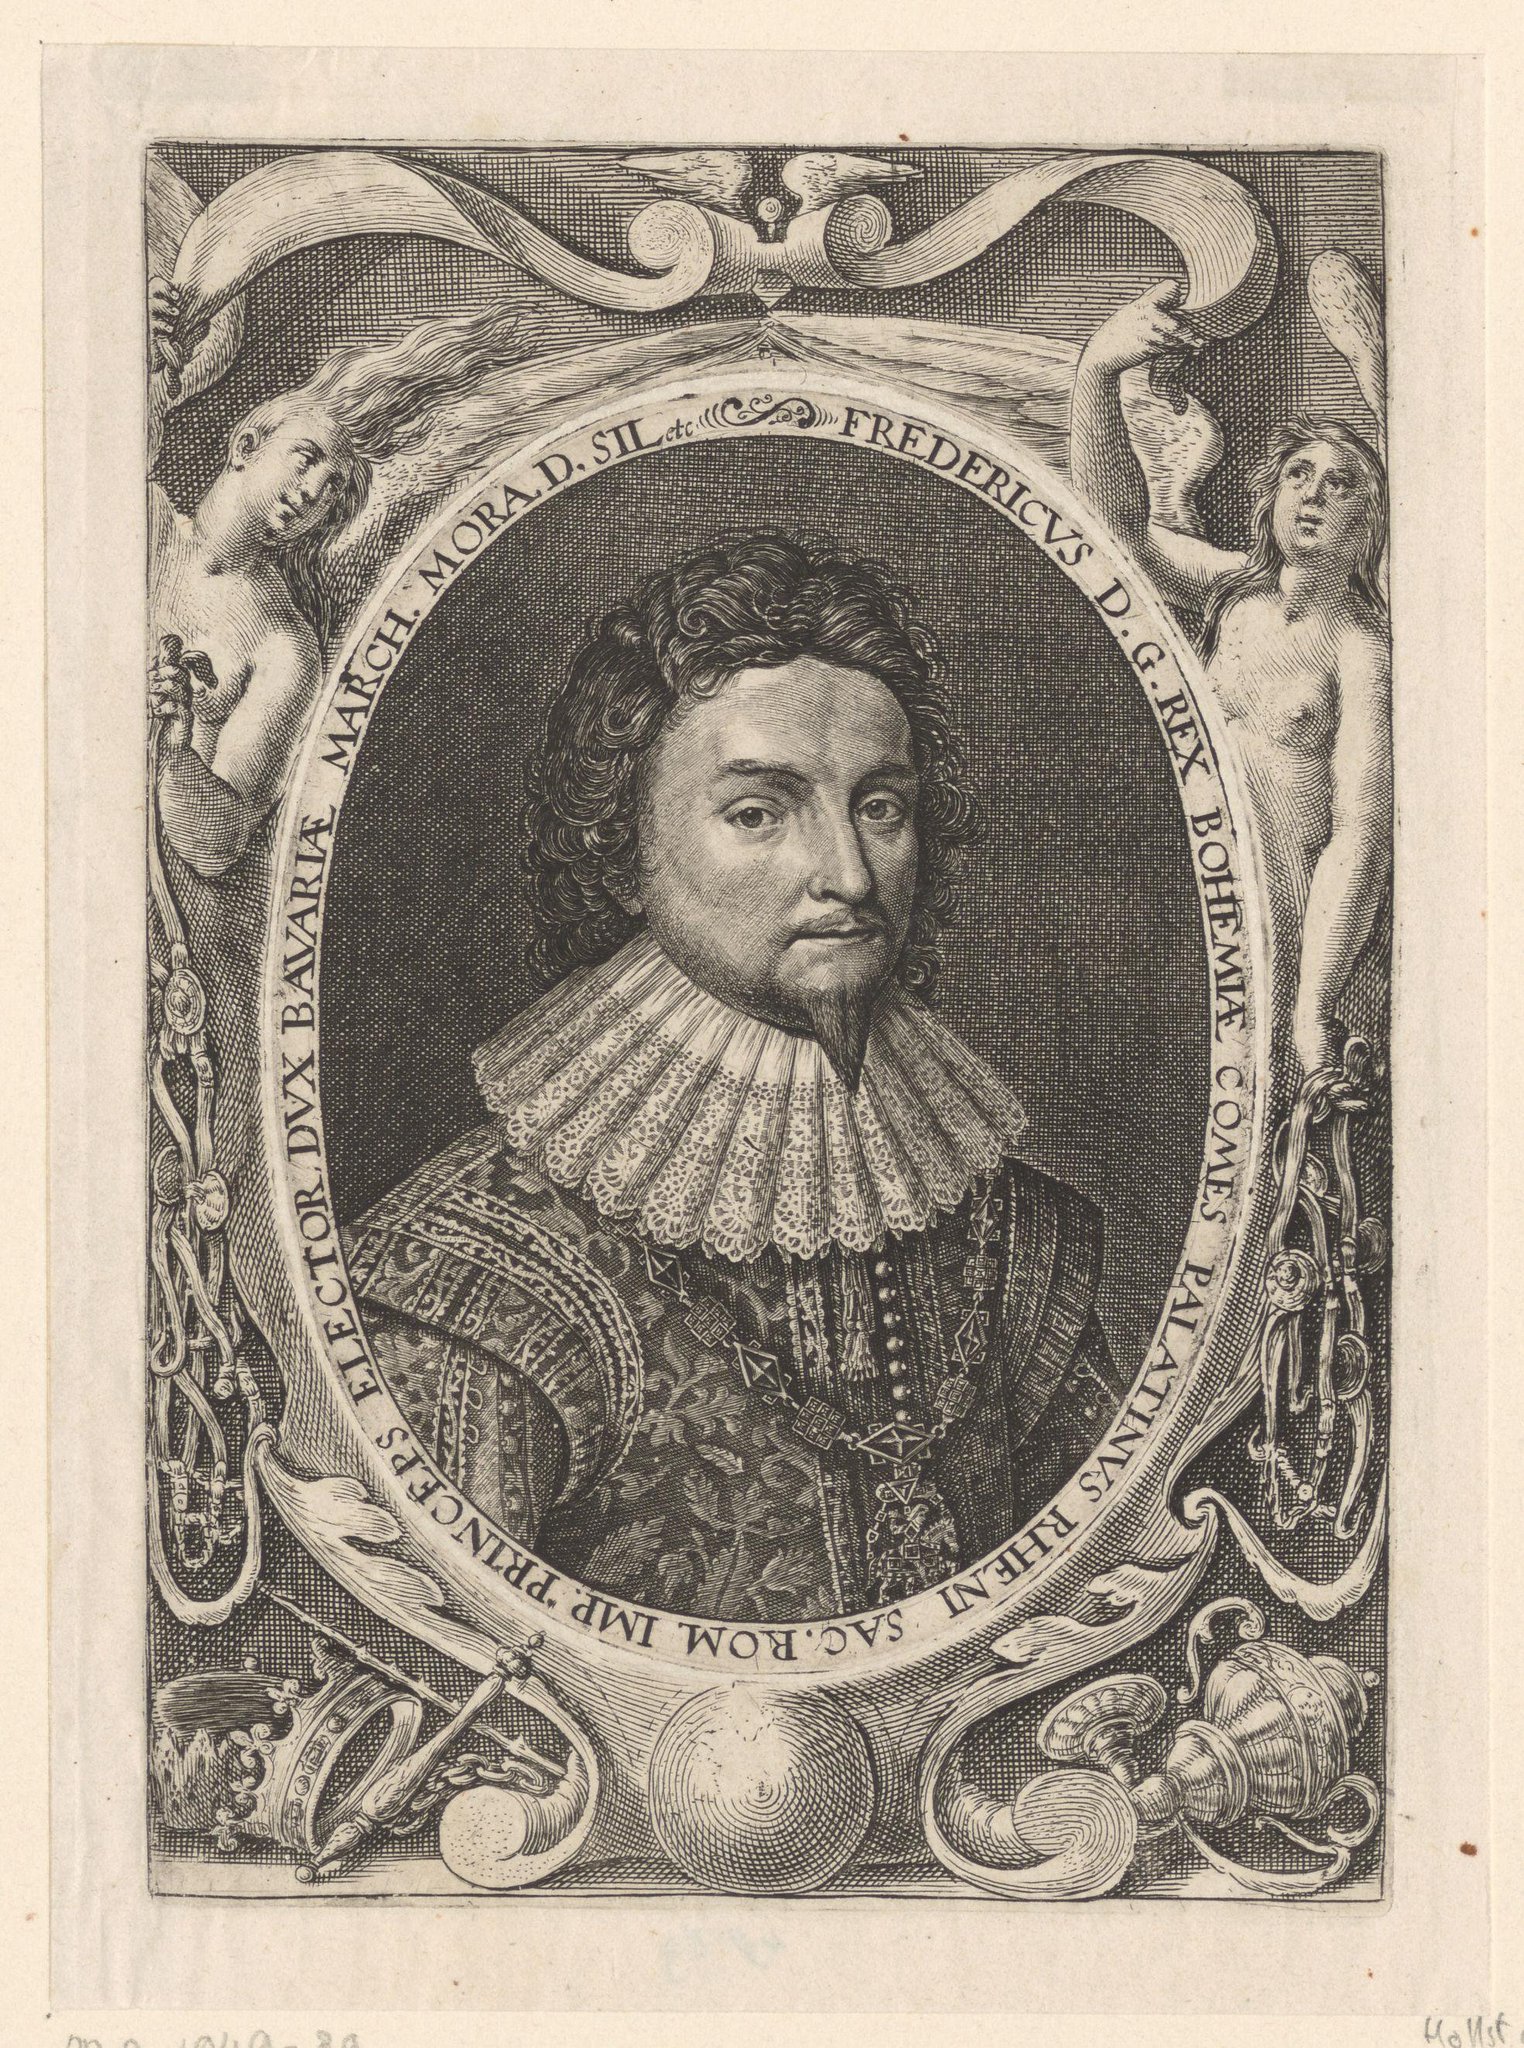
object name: print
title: Portret van Frederik V, koning van Bohemen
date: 1638-1693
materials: paper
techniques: engraving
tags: amberg, frederik v (keurvorst van de palts, koning van bohemen), historical persons, king